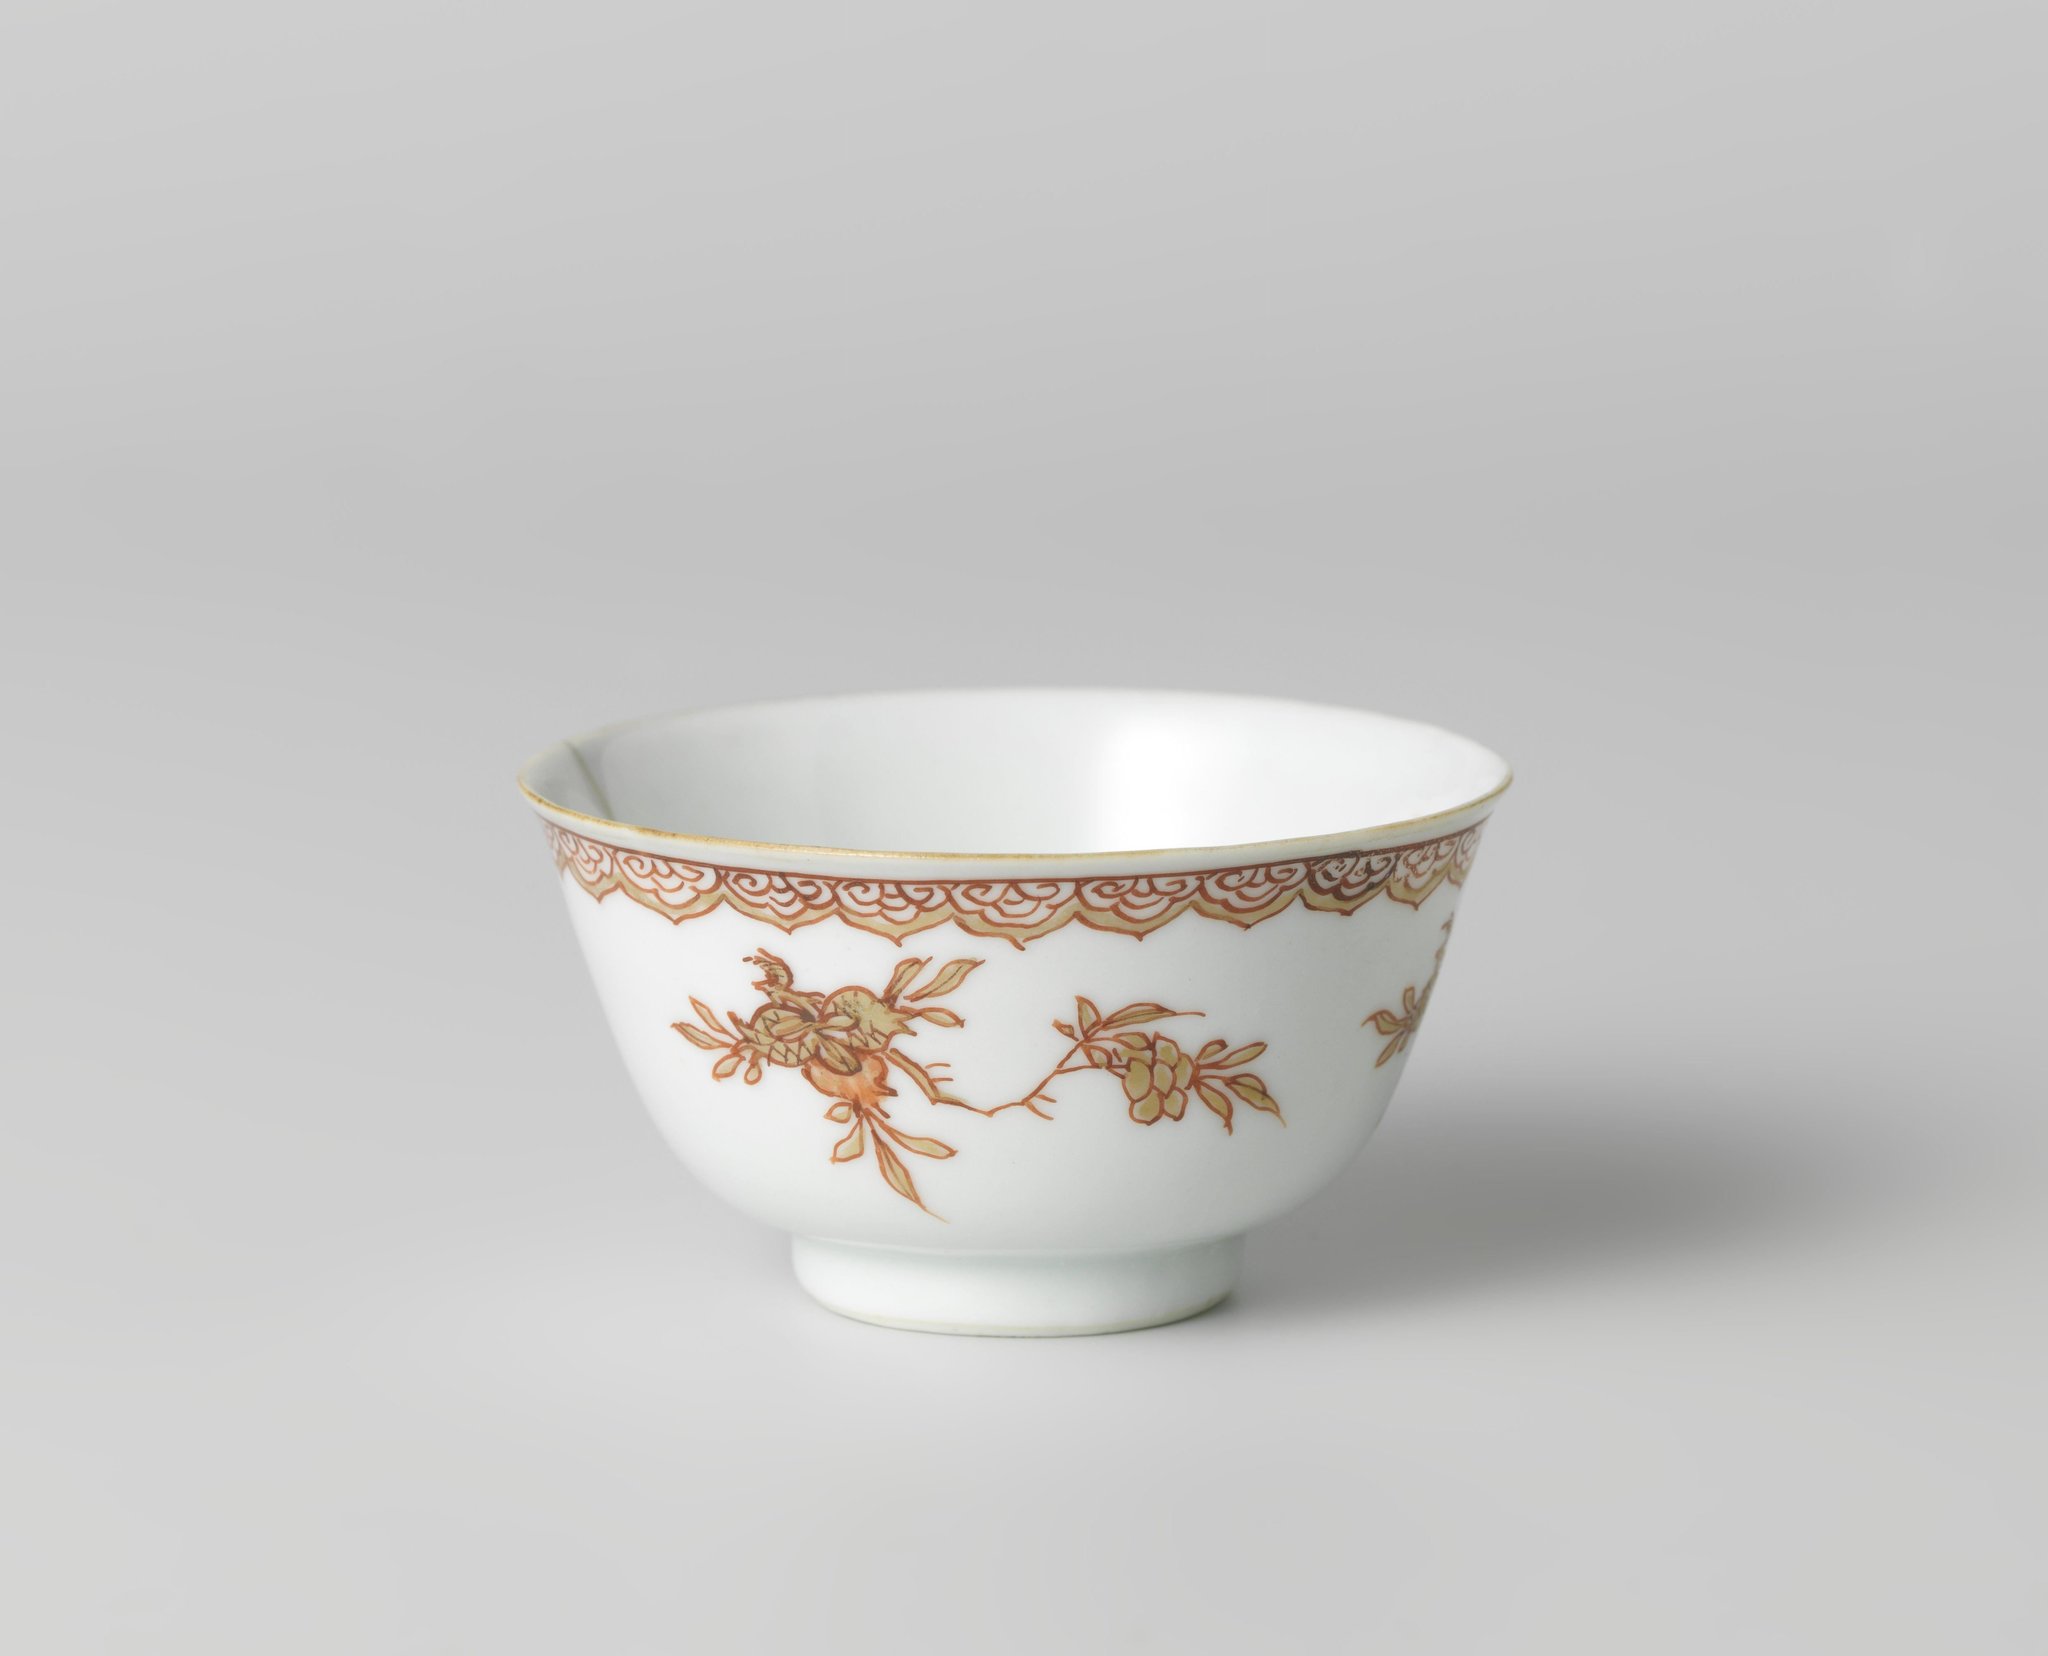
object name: kop en schotel, kop en schotel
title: Cup with fruit sprays and ruyi-border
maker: Anonymous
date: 1725-1749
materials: glaze, gold, paint, porcelain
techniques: firing, gilding, turning, vitrification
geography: china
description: Kop van porselein, beschilderd op het glazuur met rood en goud. Een tak in een medaillon met daaromheen drie fruittakken afgebeeld, om de rand een band met ruyi-motief; op de bodem een tak. Een barst in de wand. Melk en bloed.